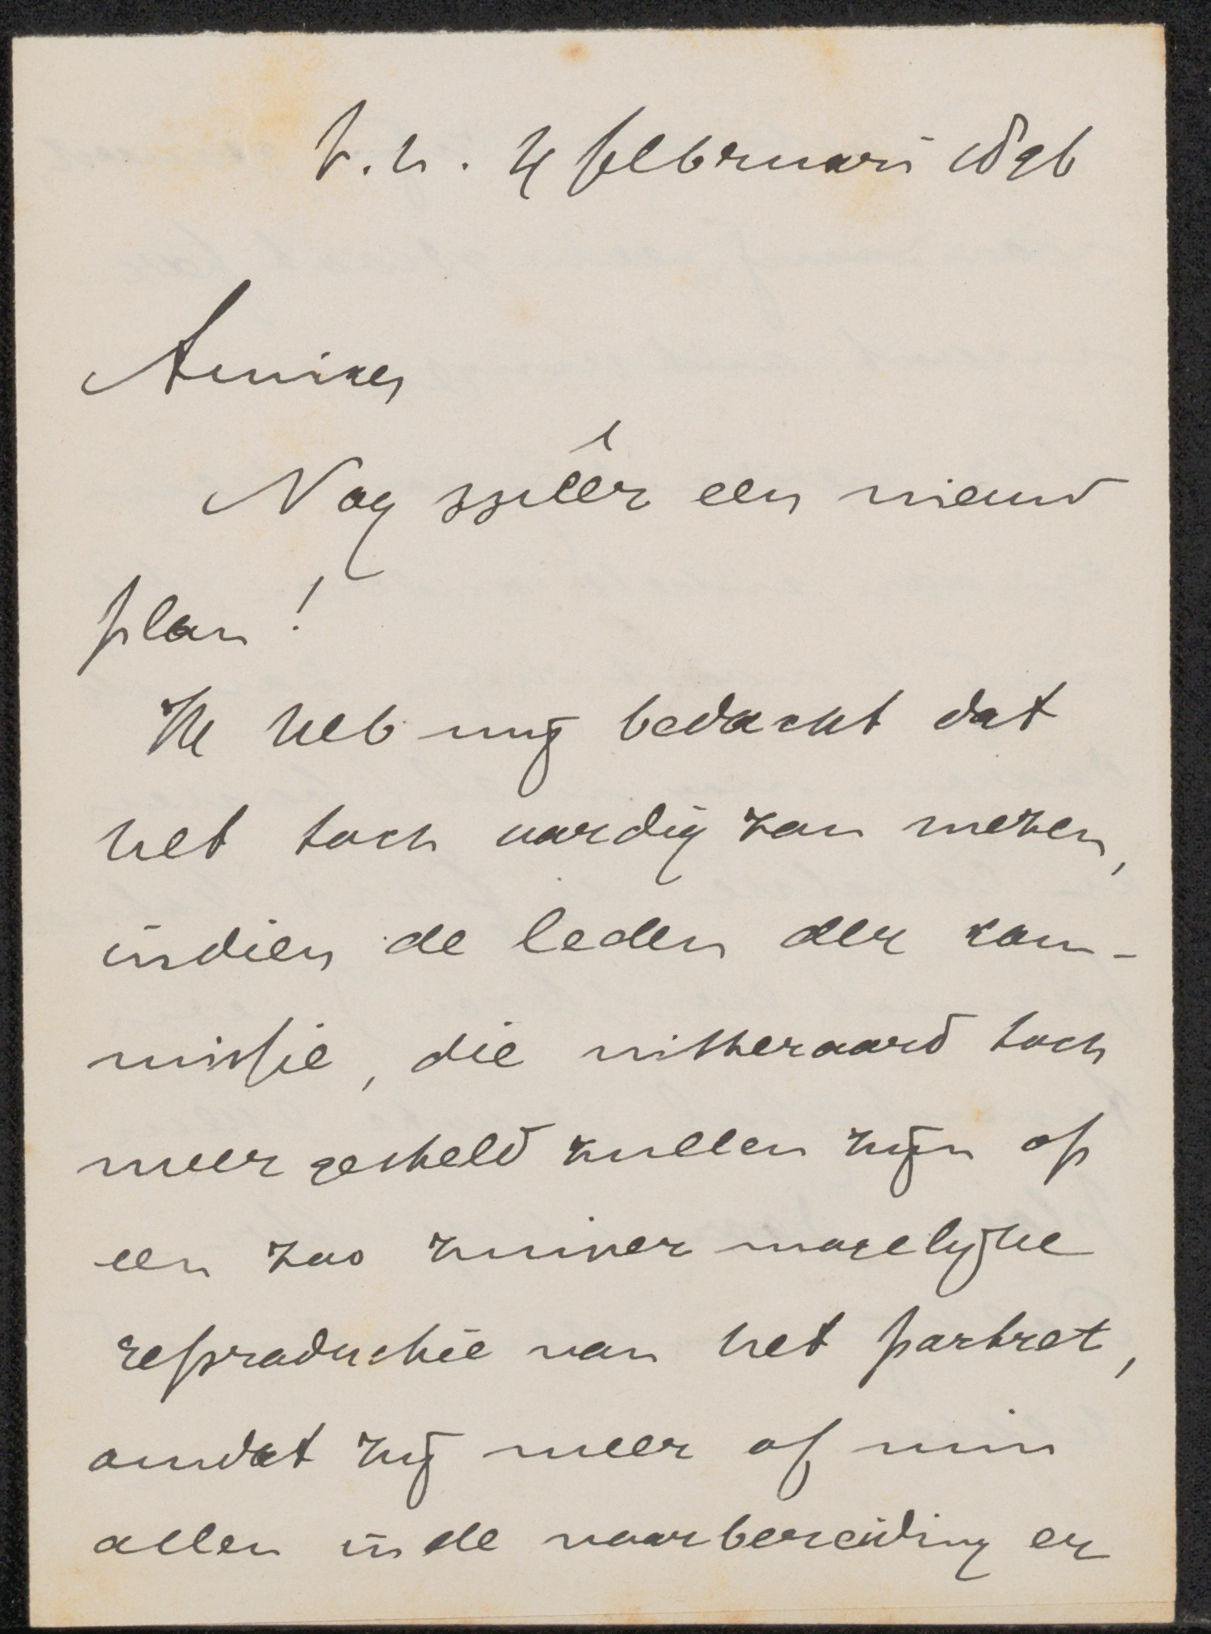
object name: letter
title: Brief aan Jan Veth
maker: jacob pieter moltzer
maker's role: jurist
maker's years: 1850-1907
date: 1896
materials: ink, paper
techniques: pen, writing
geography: the hague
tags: dordrecht, painter, print maker, draughtsman, designer, jan veth, historical persons (portraits and scenes from the life), amsterdam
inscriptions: collector's mark: ‘RPK’